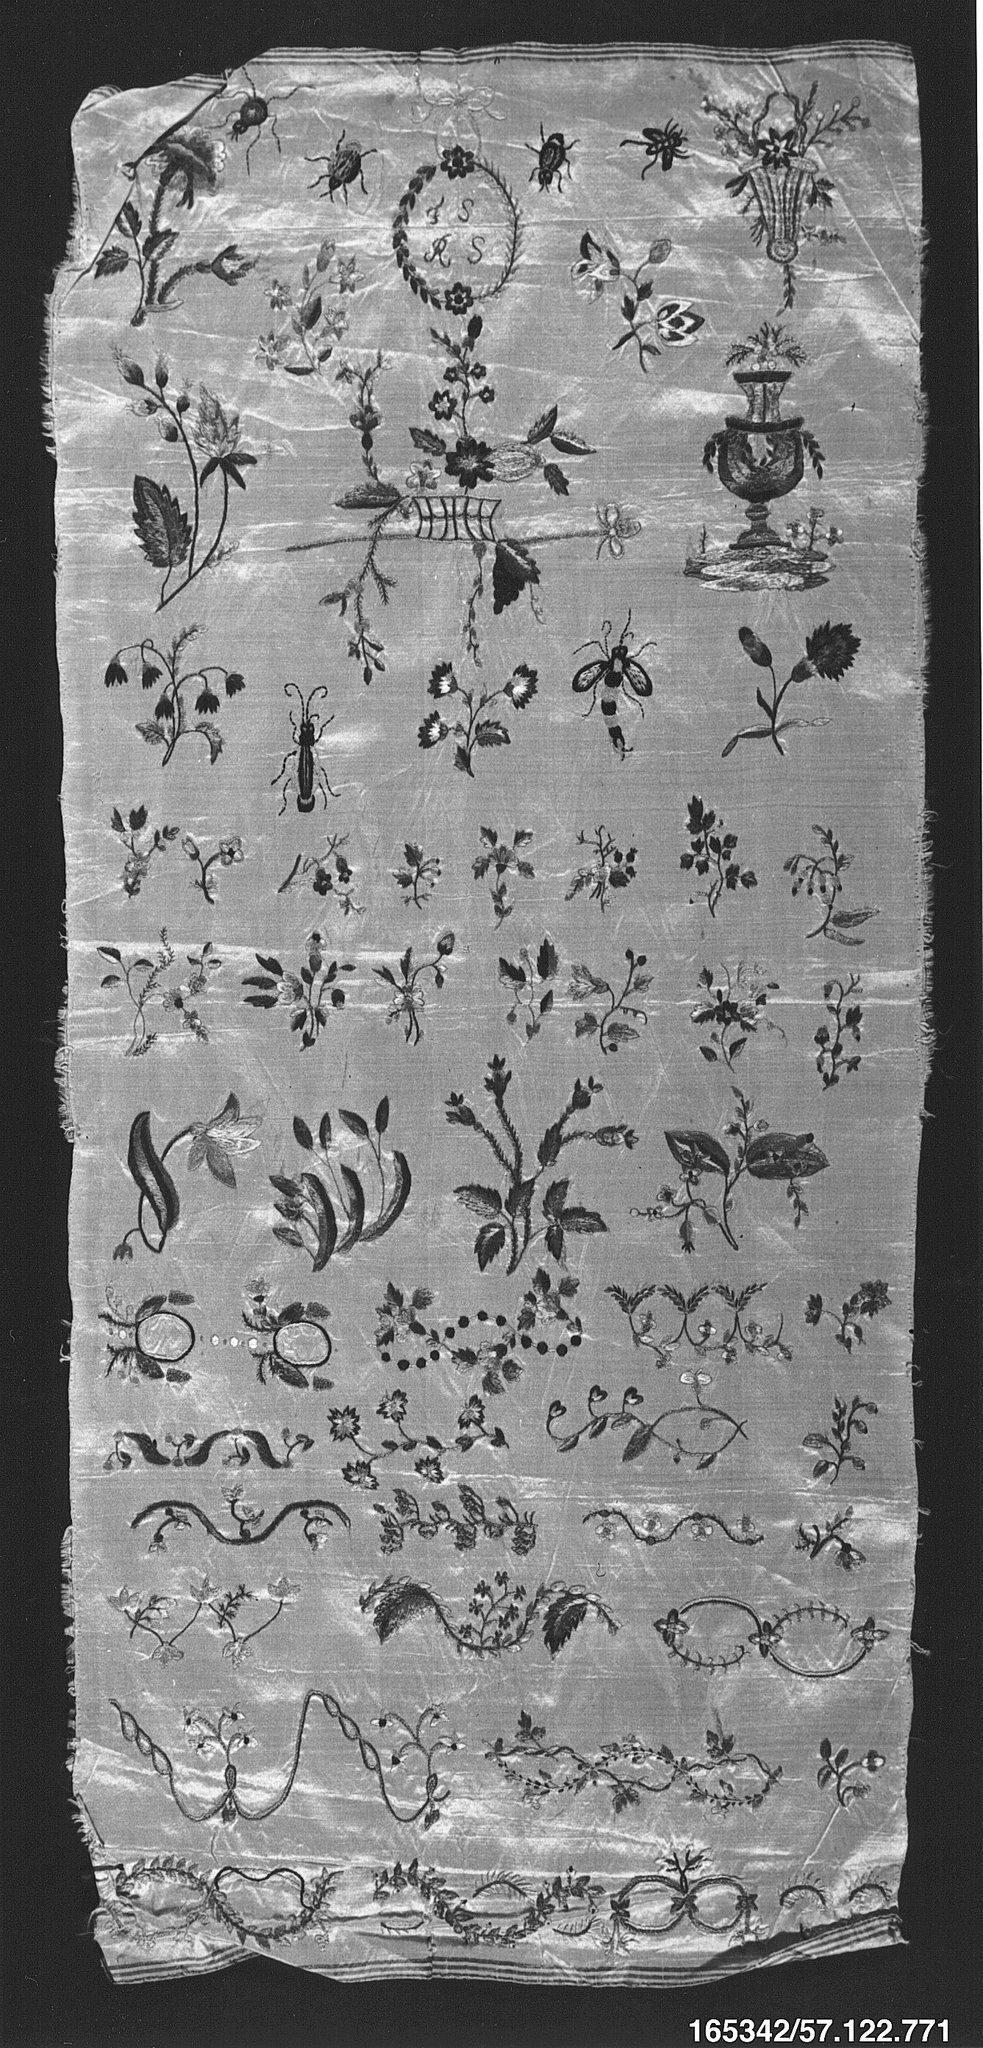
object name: sampler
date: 1801-1900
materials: silk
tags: flowers,leaves